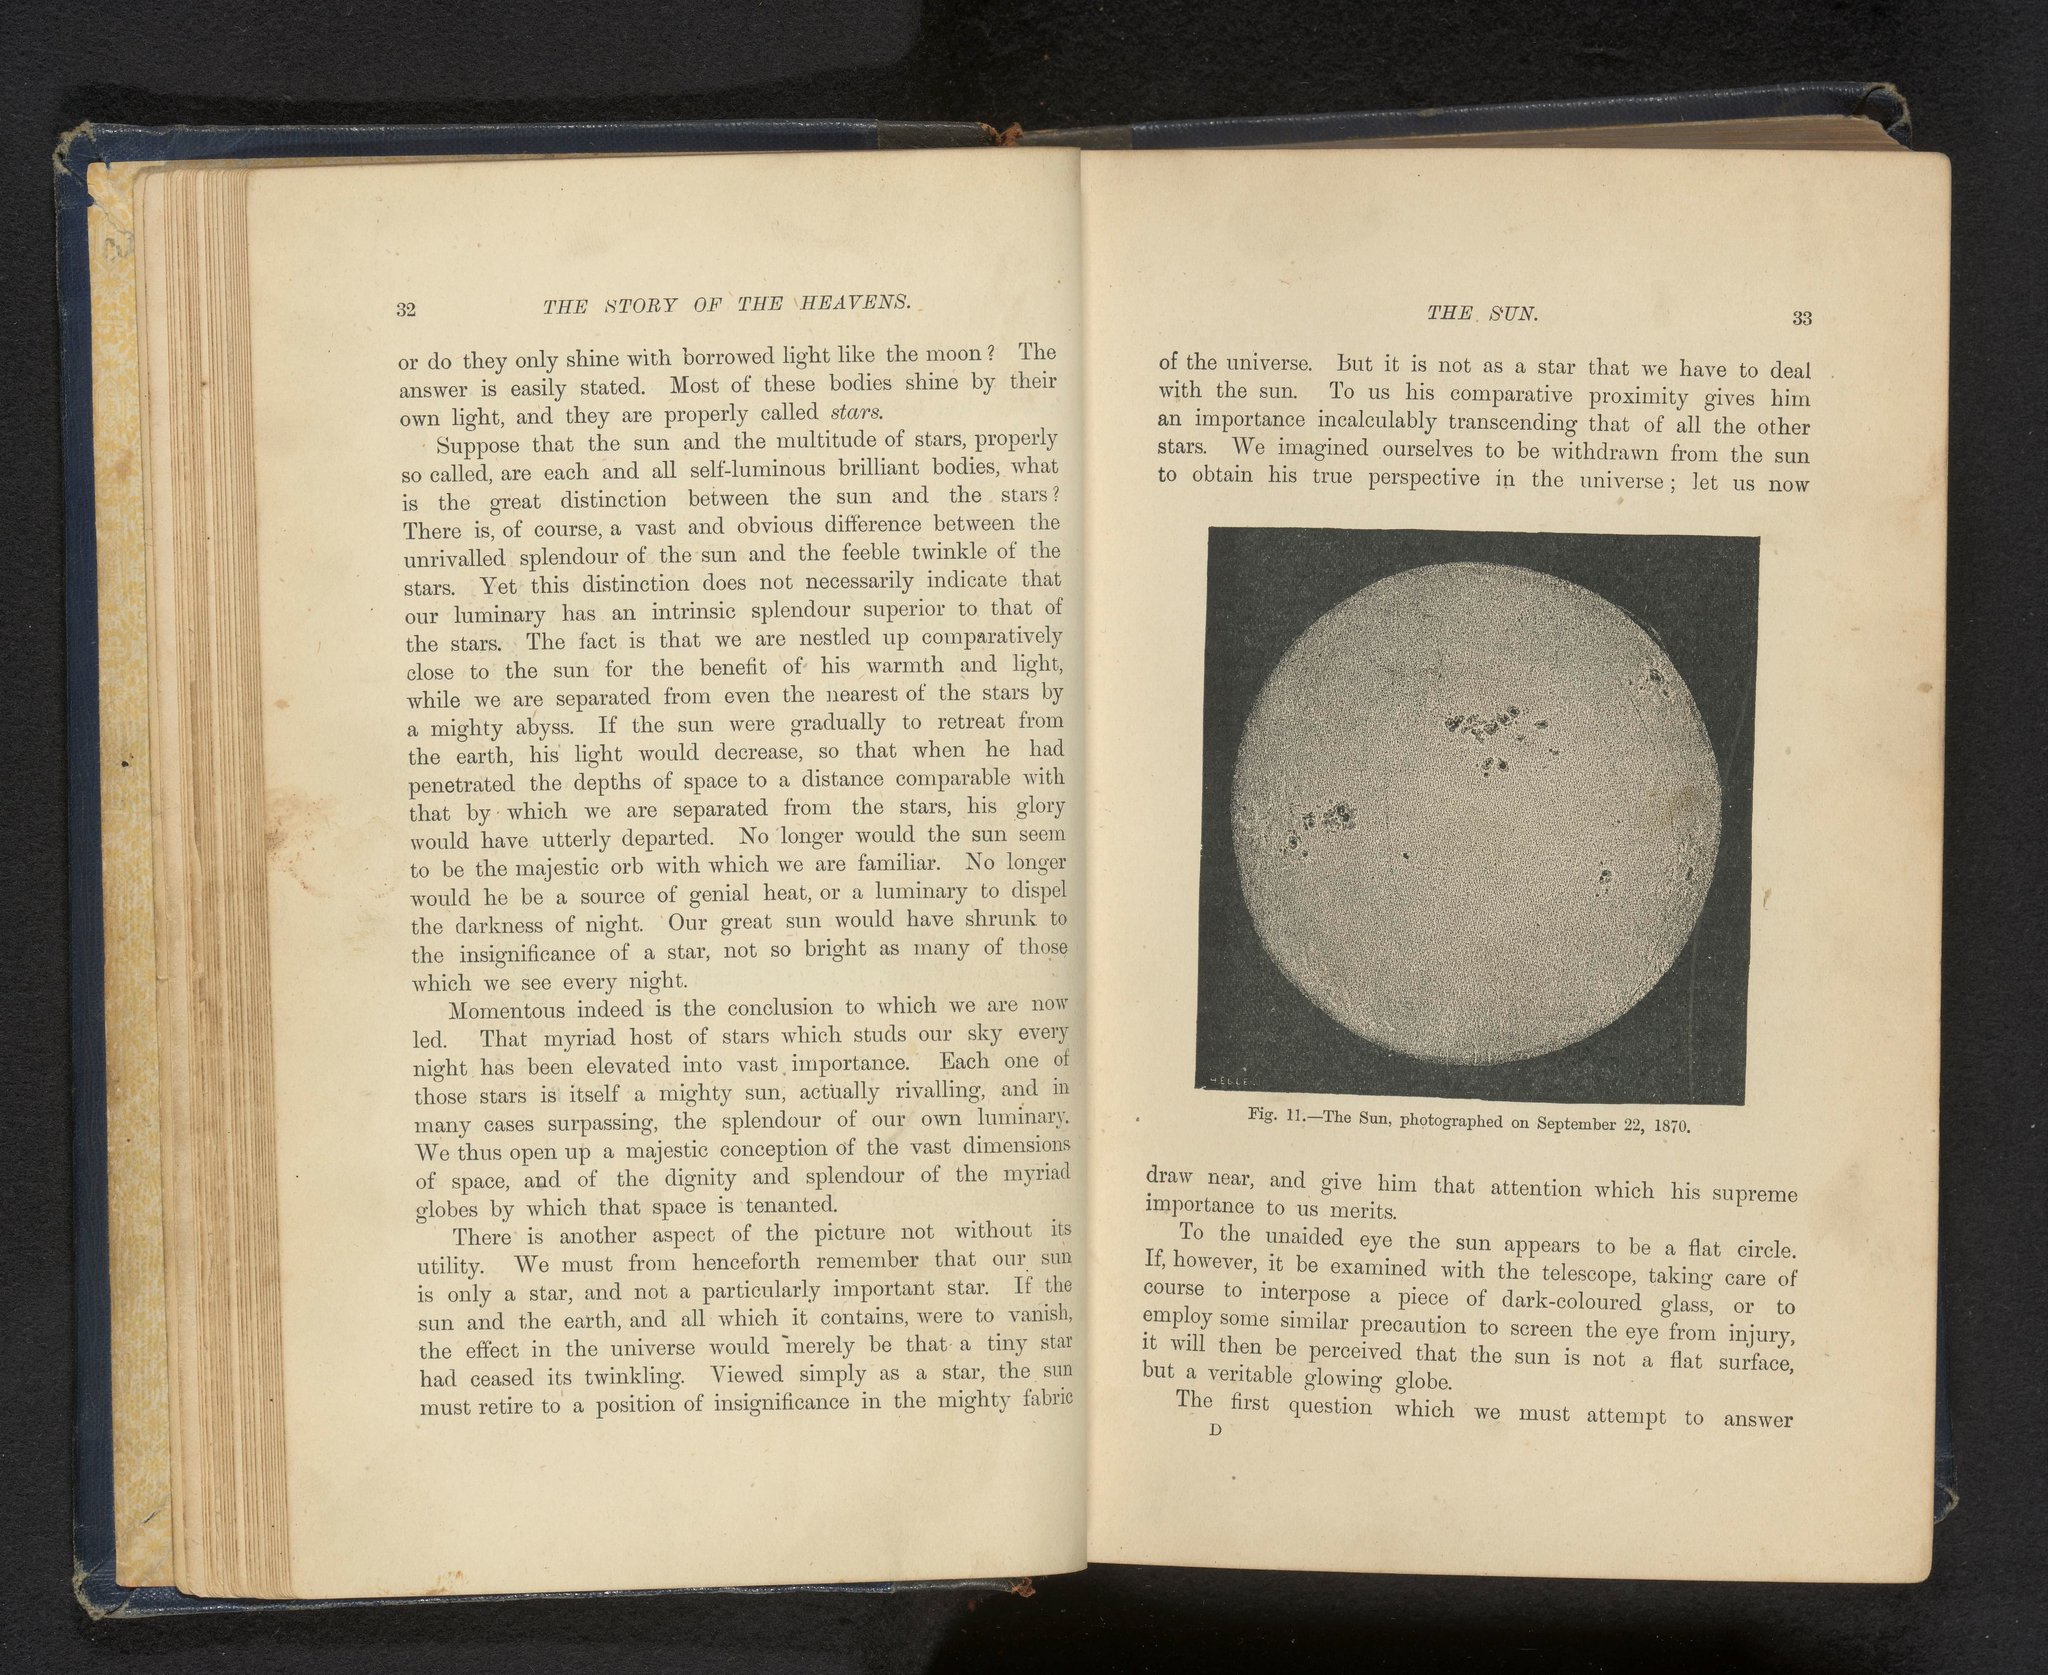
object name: page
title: Zon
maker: Anonymous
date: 1870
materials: paper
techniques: photolithography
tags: sun as celestial body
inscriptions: inscription: ‘Helle’, number: ‘Fig. 11.’, inscription: ‘The Sun, photographed on September 22, 1870.’